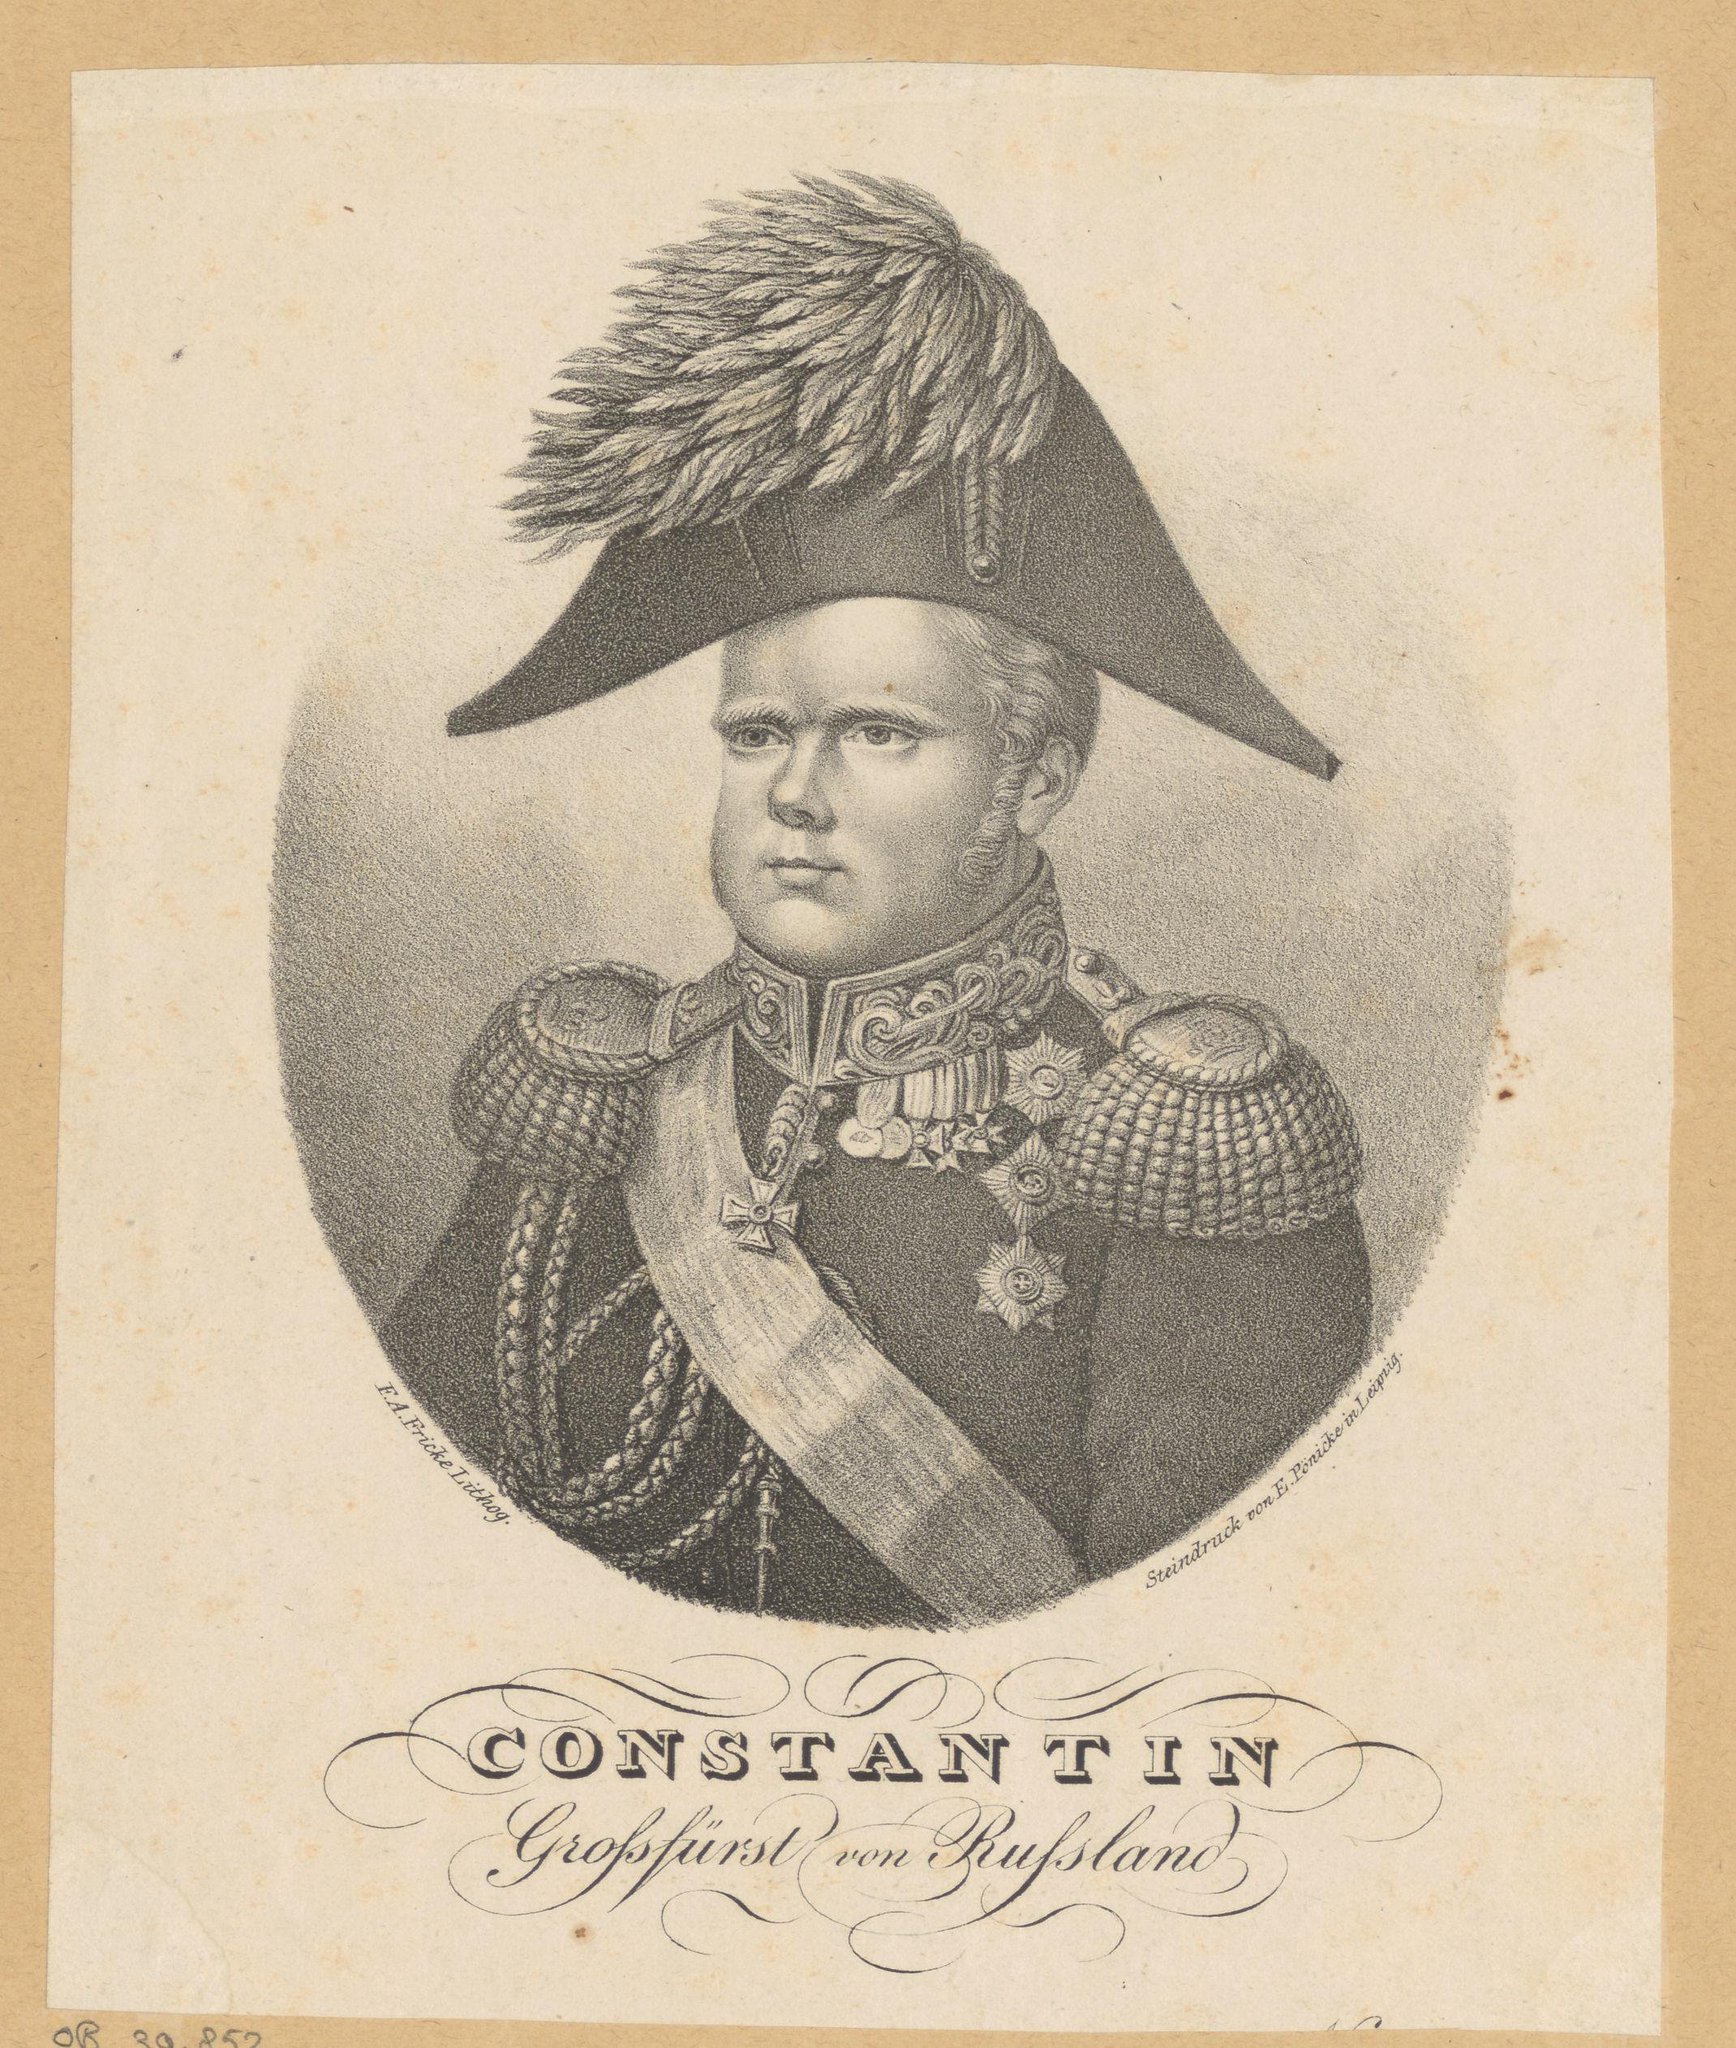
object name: print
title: Portret van Constantijn Pavlovitsj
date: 1820-1850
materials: paper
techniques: lithograph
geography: leipzig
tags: adult man, historical persons, (military) uniforms